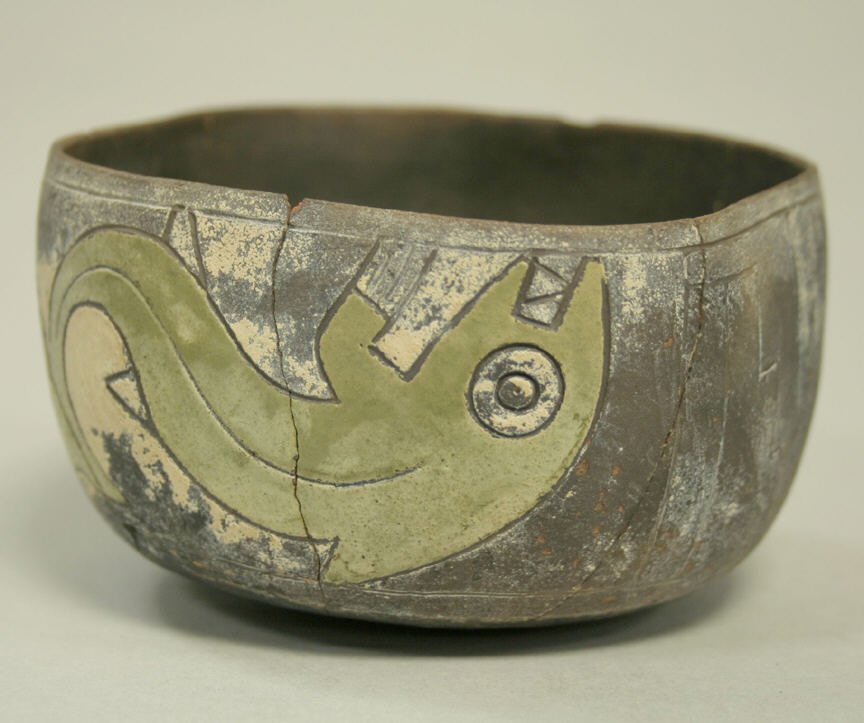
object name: bowl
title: Painted Bowl with Whale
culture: paracas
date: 600-301 BCE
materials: ceramic, pigment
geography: peru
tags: whales